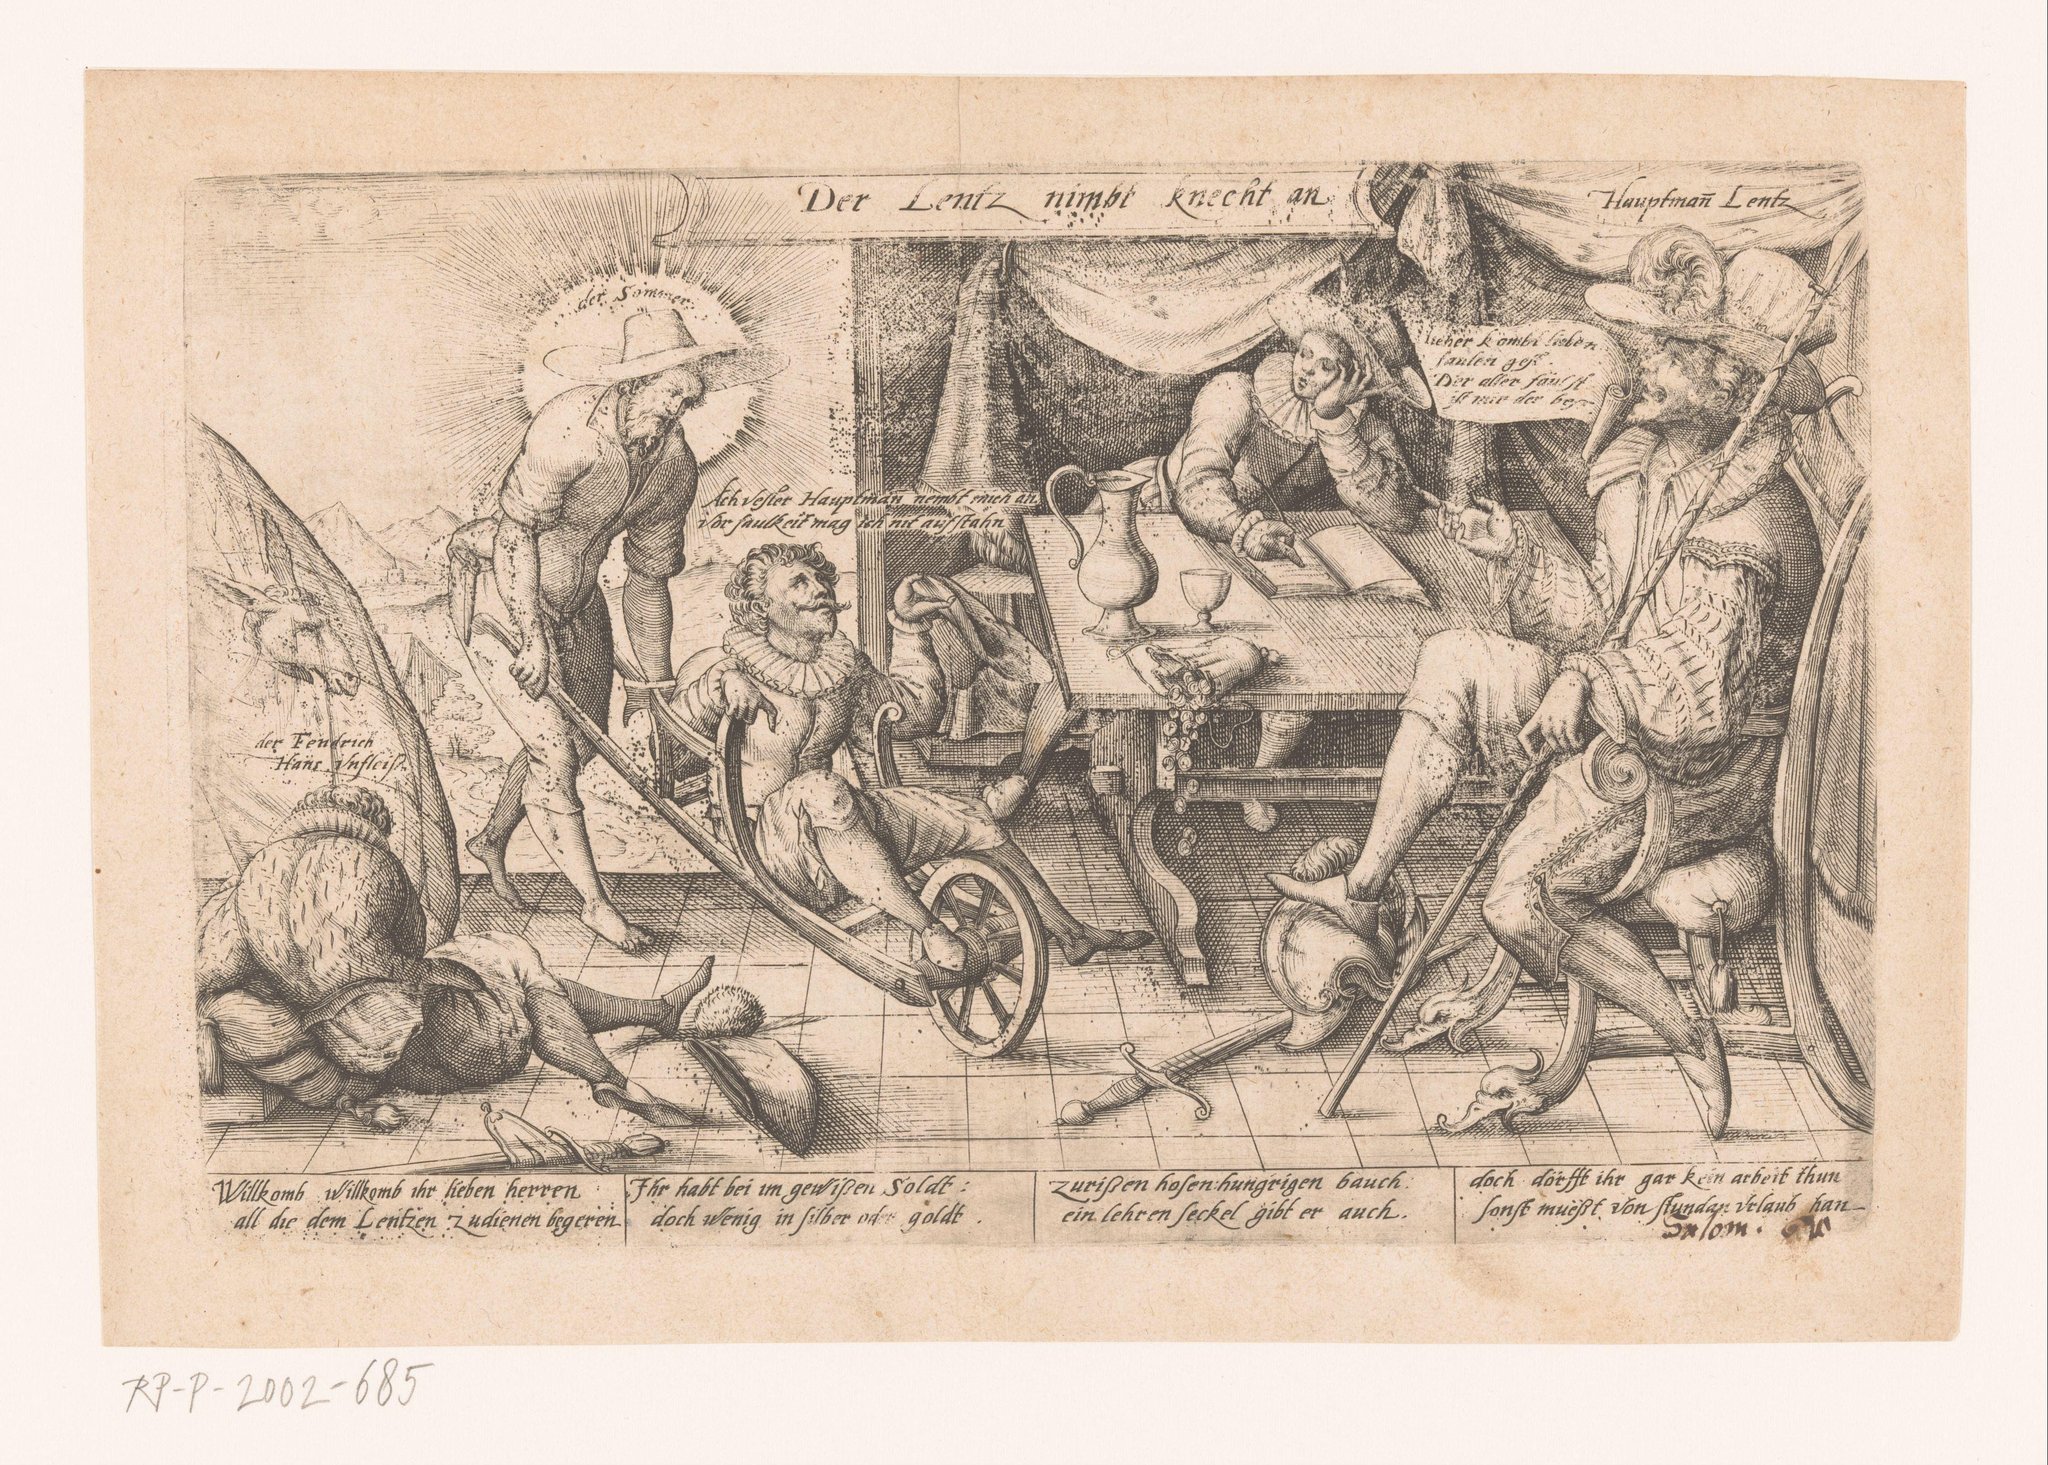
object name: cartoon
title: Spotprent op de luiheid van de landsknecht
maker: Anonymous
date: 1596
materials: paper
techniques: engraving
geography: germany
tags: official; civil servant; functionary (in general), sluggishness, inertia; 'dapocaggine', 'pigritia' (ripa)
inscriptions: collector's mark: Lugt 2228, : ‘Salom. (...)’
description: Spotprent op de luiheid van de landsknecht. Rechtsvoor zit 'Hauptman Lentz' op een stoel. Links wordt een man in een kruiwagen naar hem toe gereden door 'der Sommer'. Deze luiaard wil bij hem in dienst. Onder een baldakijn een administrateur aan een tafel met open boek voor zich. Links ligt 'Fendrich Hans Unfleisch' op de grond te slapen. Titel in cartouche: 'Der Lentz nimbt Knecht an'. Andere verklarende teksten op banderollen in de voorstelling. Vertaalde titel: wij dommen volgen de luiheid en de slaperigheid.